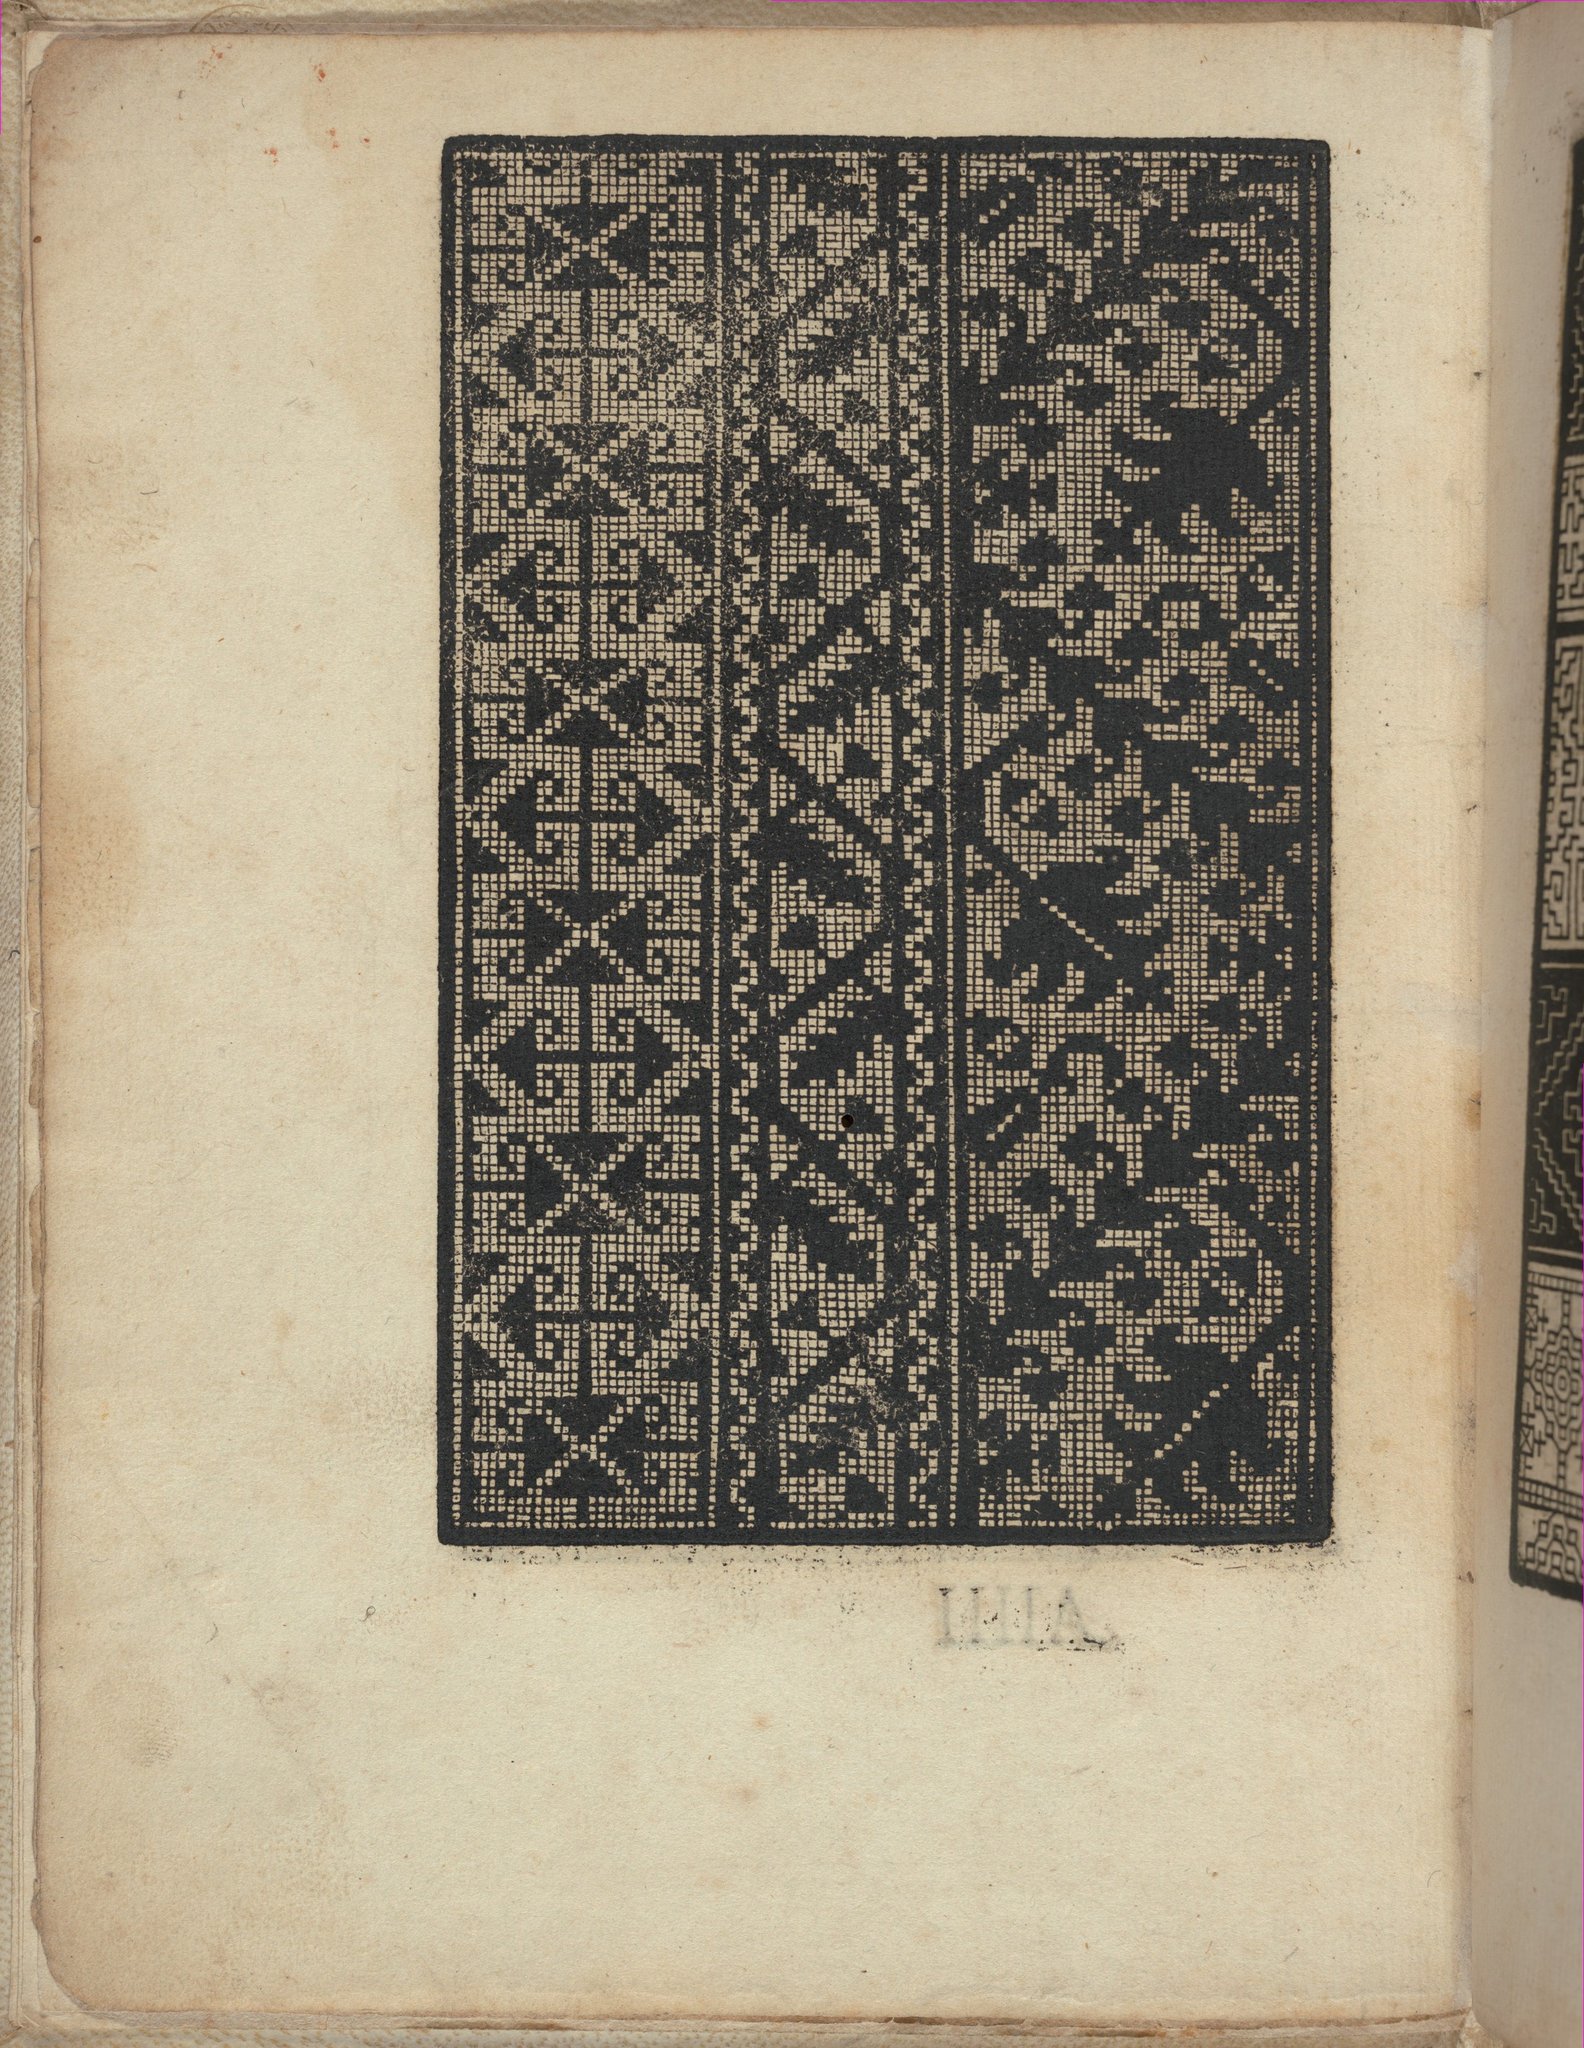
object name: book print ornament architecture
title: Esemplario di Lauori..., page 3 (verso)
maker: giovanni andrea vavassore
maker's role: publisher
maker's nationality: italian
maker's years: 1530-1573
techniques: woodcut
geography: venice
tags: ornament